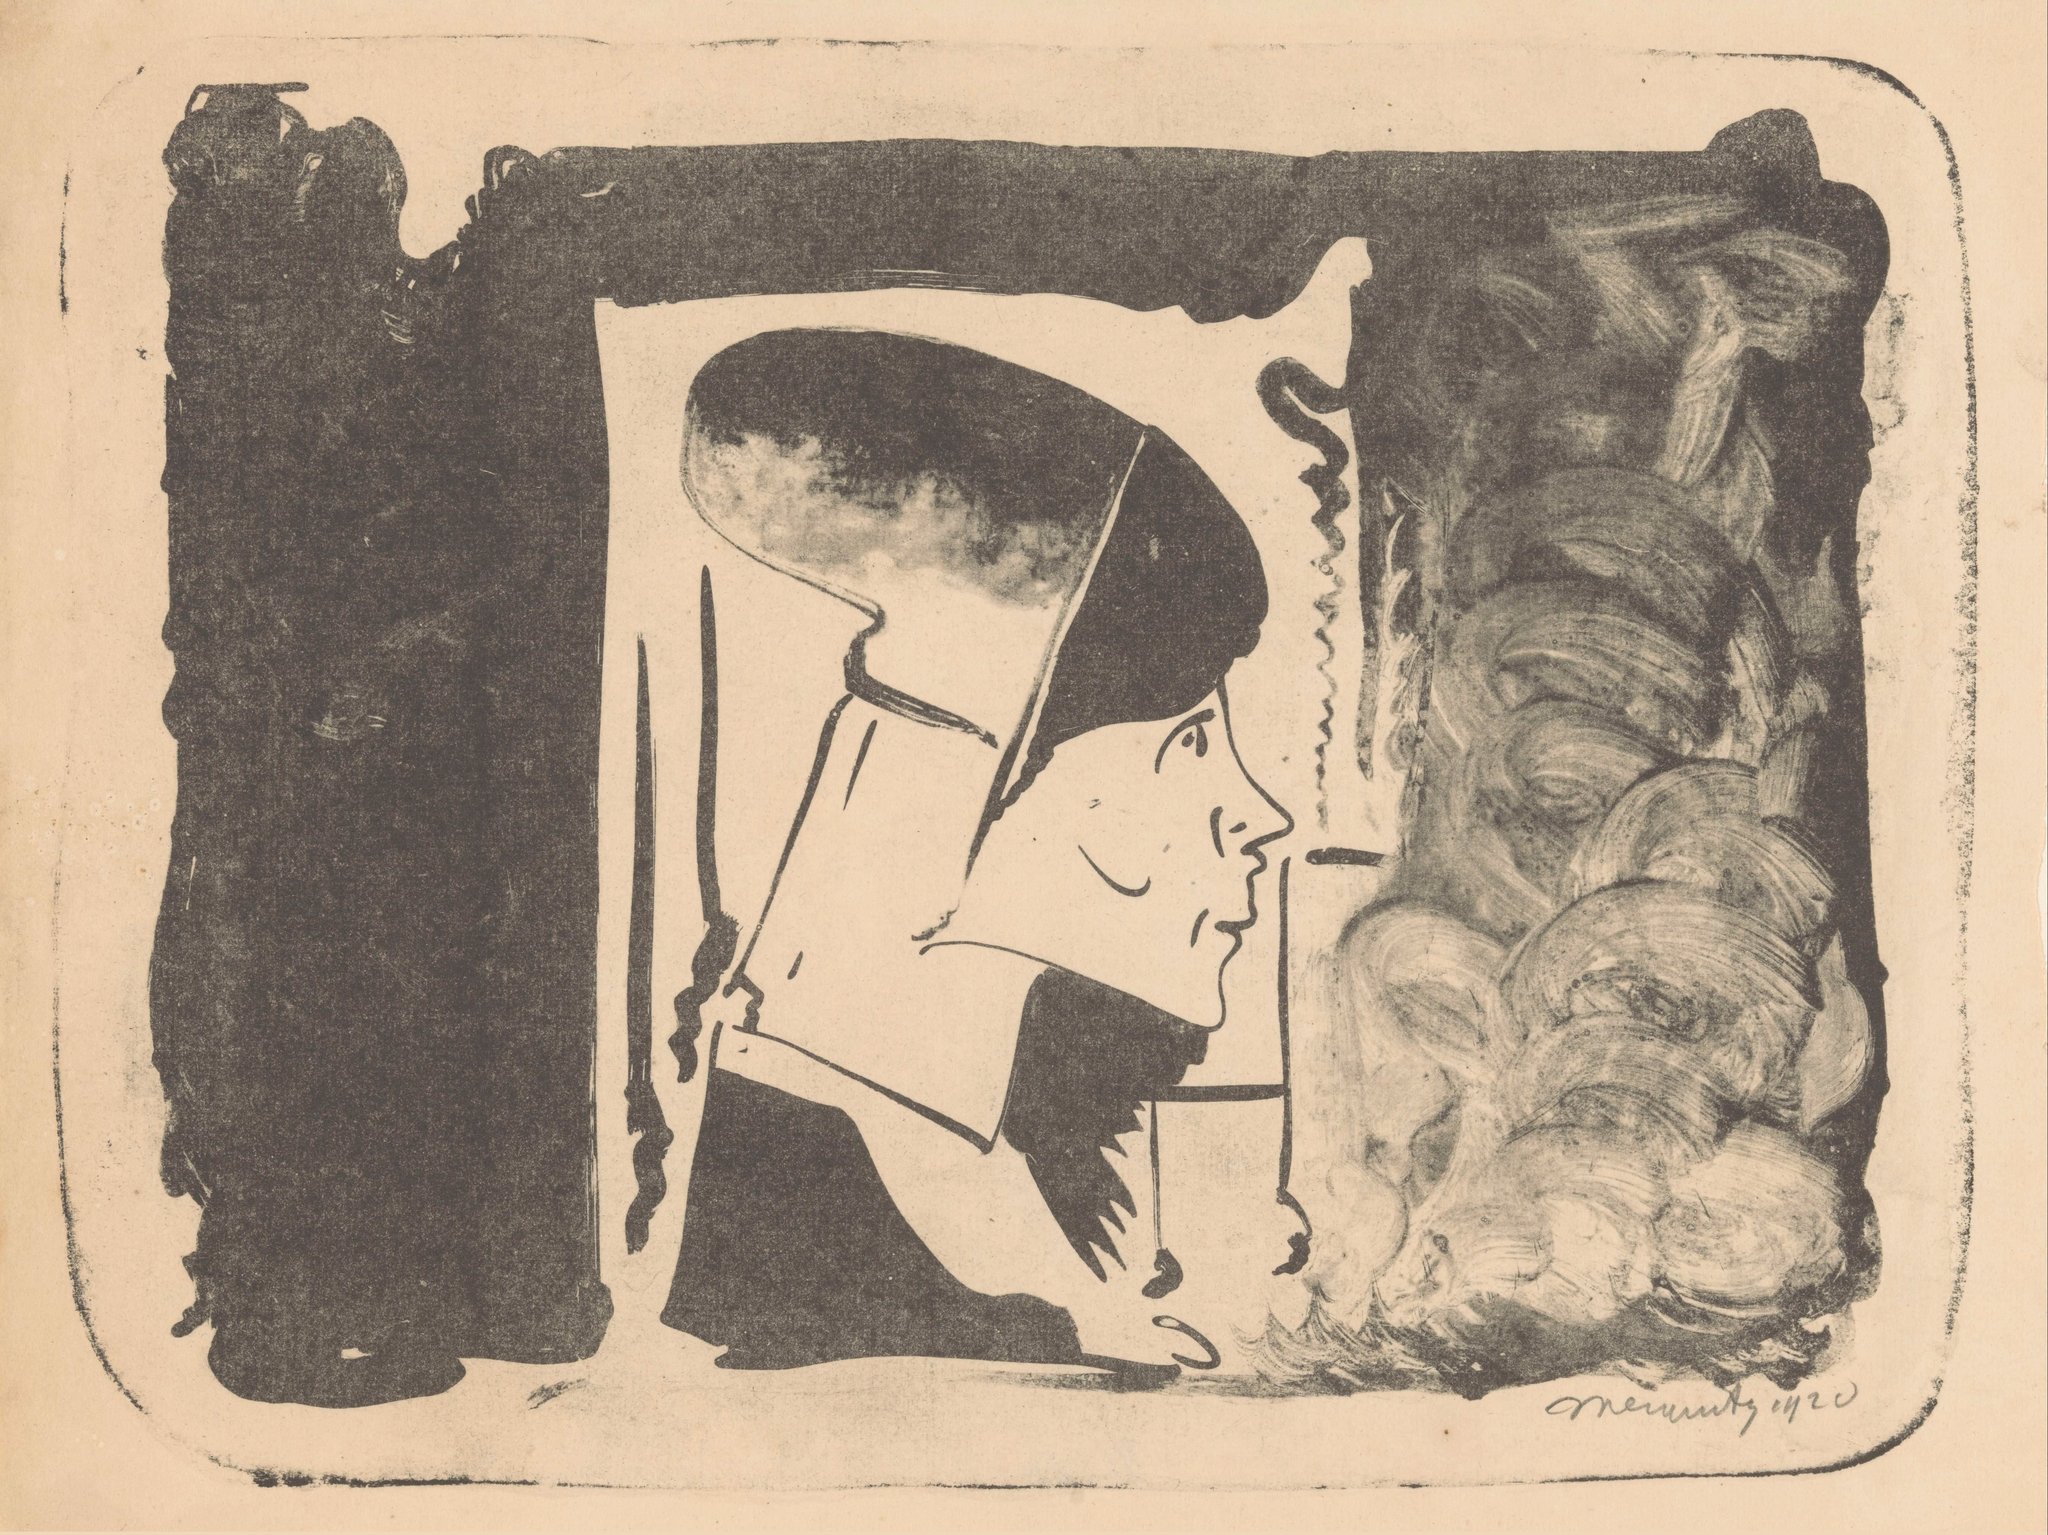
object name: print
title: Fantasie: profielkop naar rechts in een witte rechthoek, omgeven door zwart (rechtsonder is het zwart gewassen)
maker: samuel jessurun de mesquita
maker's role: draughtsman, print maker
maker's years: 1868-1944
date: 1920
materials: paper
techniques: lithograph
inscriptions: signature and date: ‘mesquita 1920’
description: Profielkop naar rechts in een witte rechthoek, omgeven door zwart (rechtsonder is het zwart gewassen).